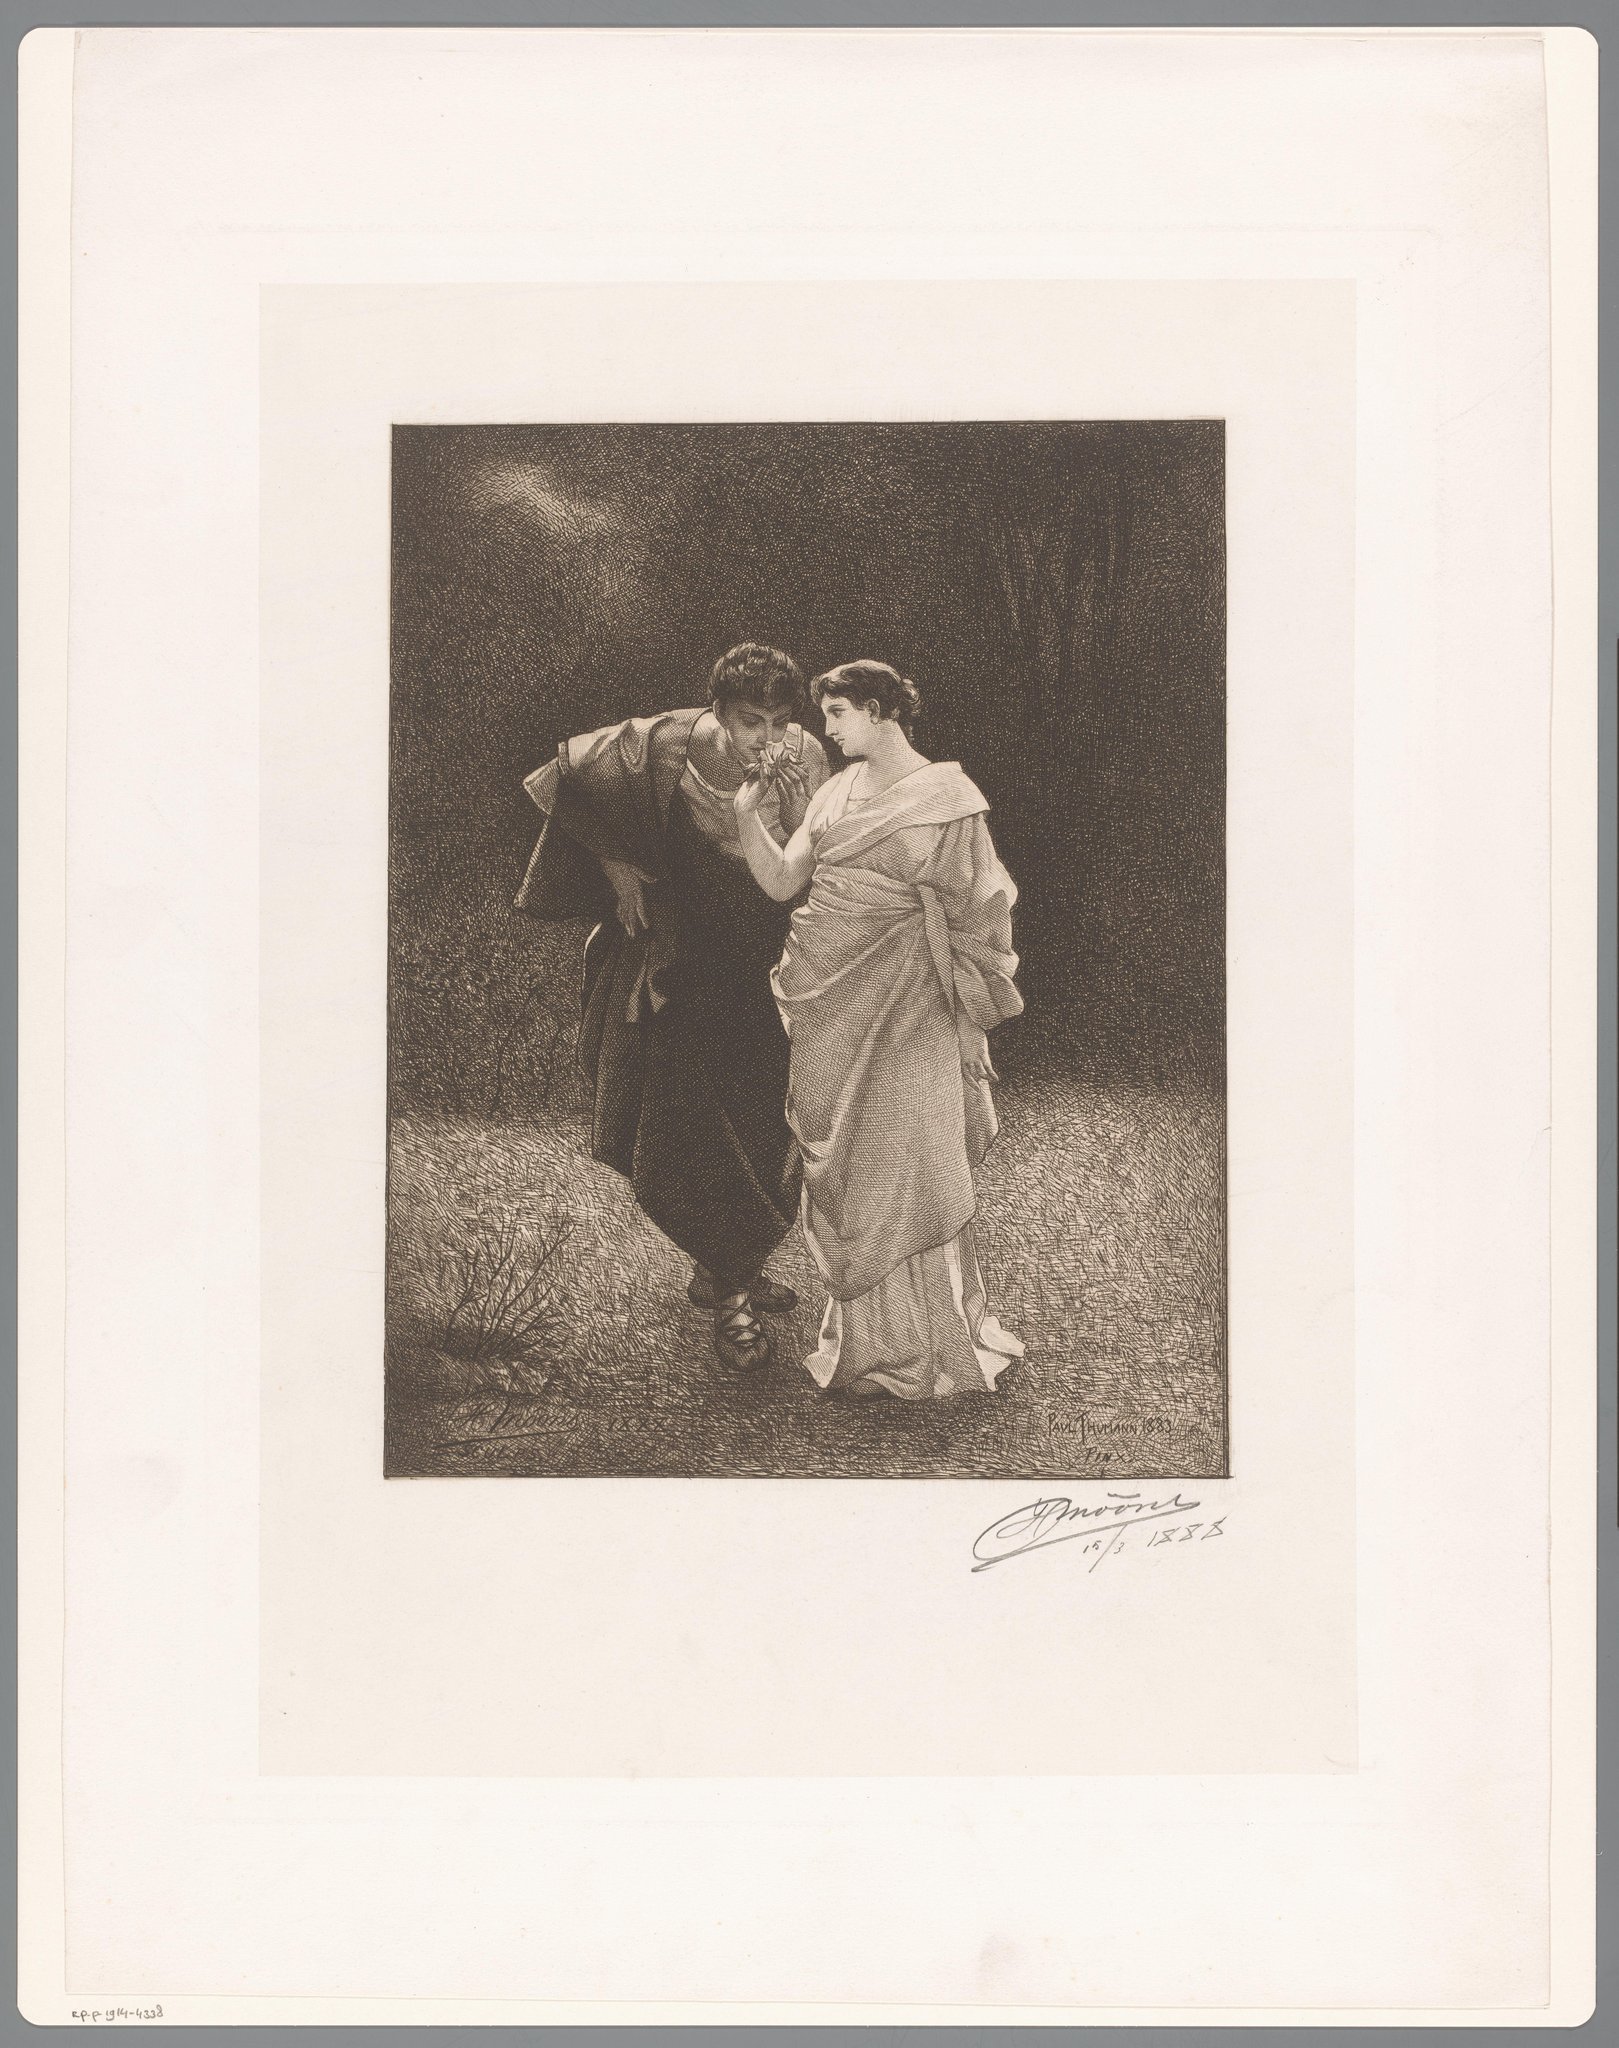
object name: print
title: Jonge man ruikt aan een bloem die een jonge vrouw vasthoudt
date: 1888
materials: paper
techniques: etching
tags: flowers, couple of lovers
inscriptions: collector's mark: Lugt 2228